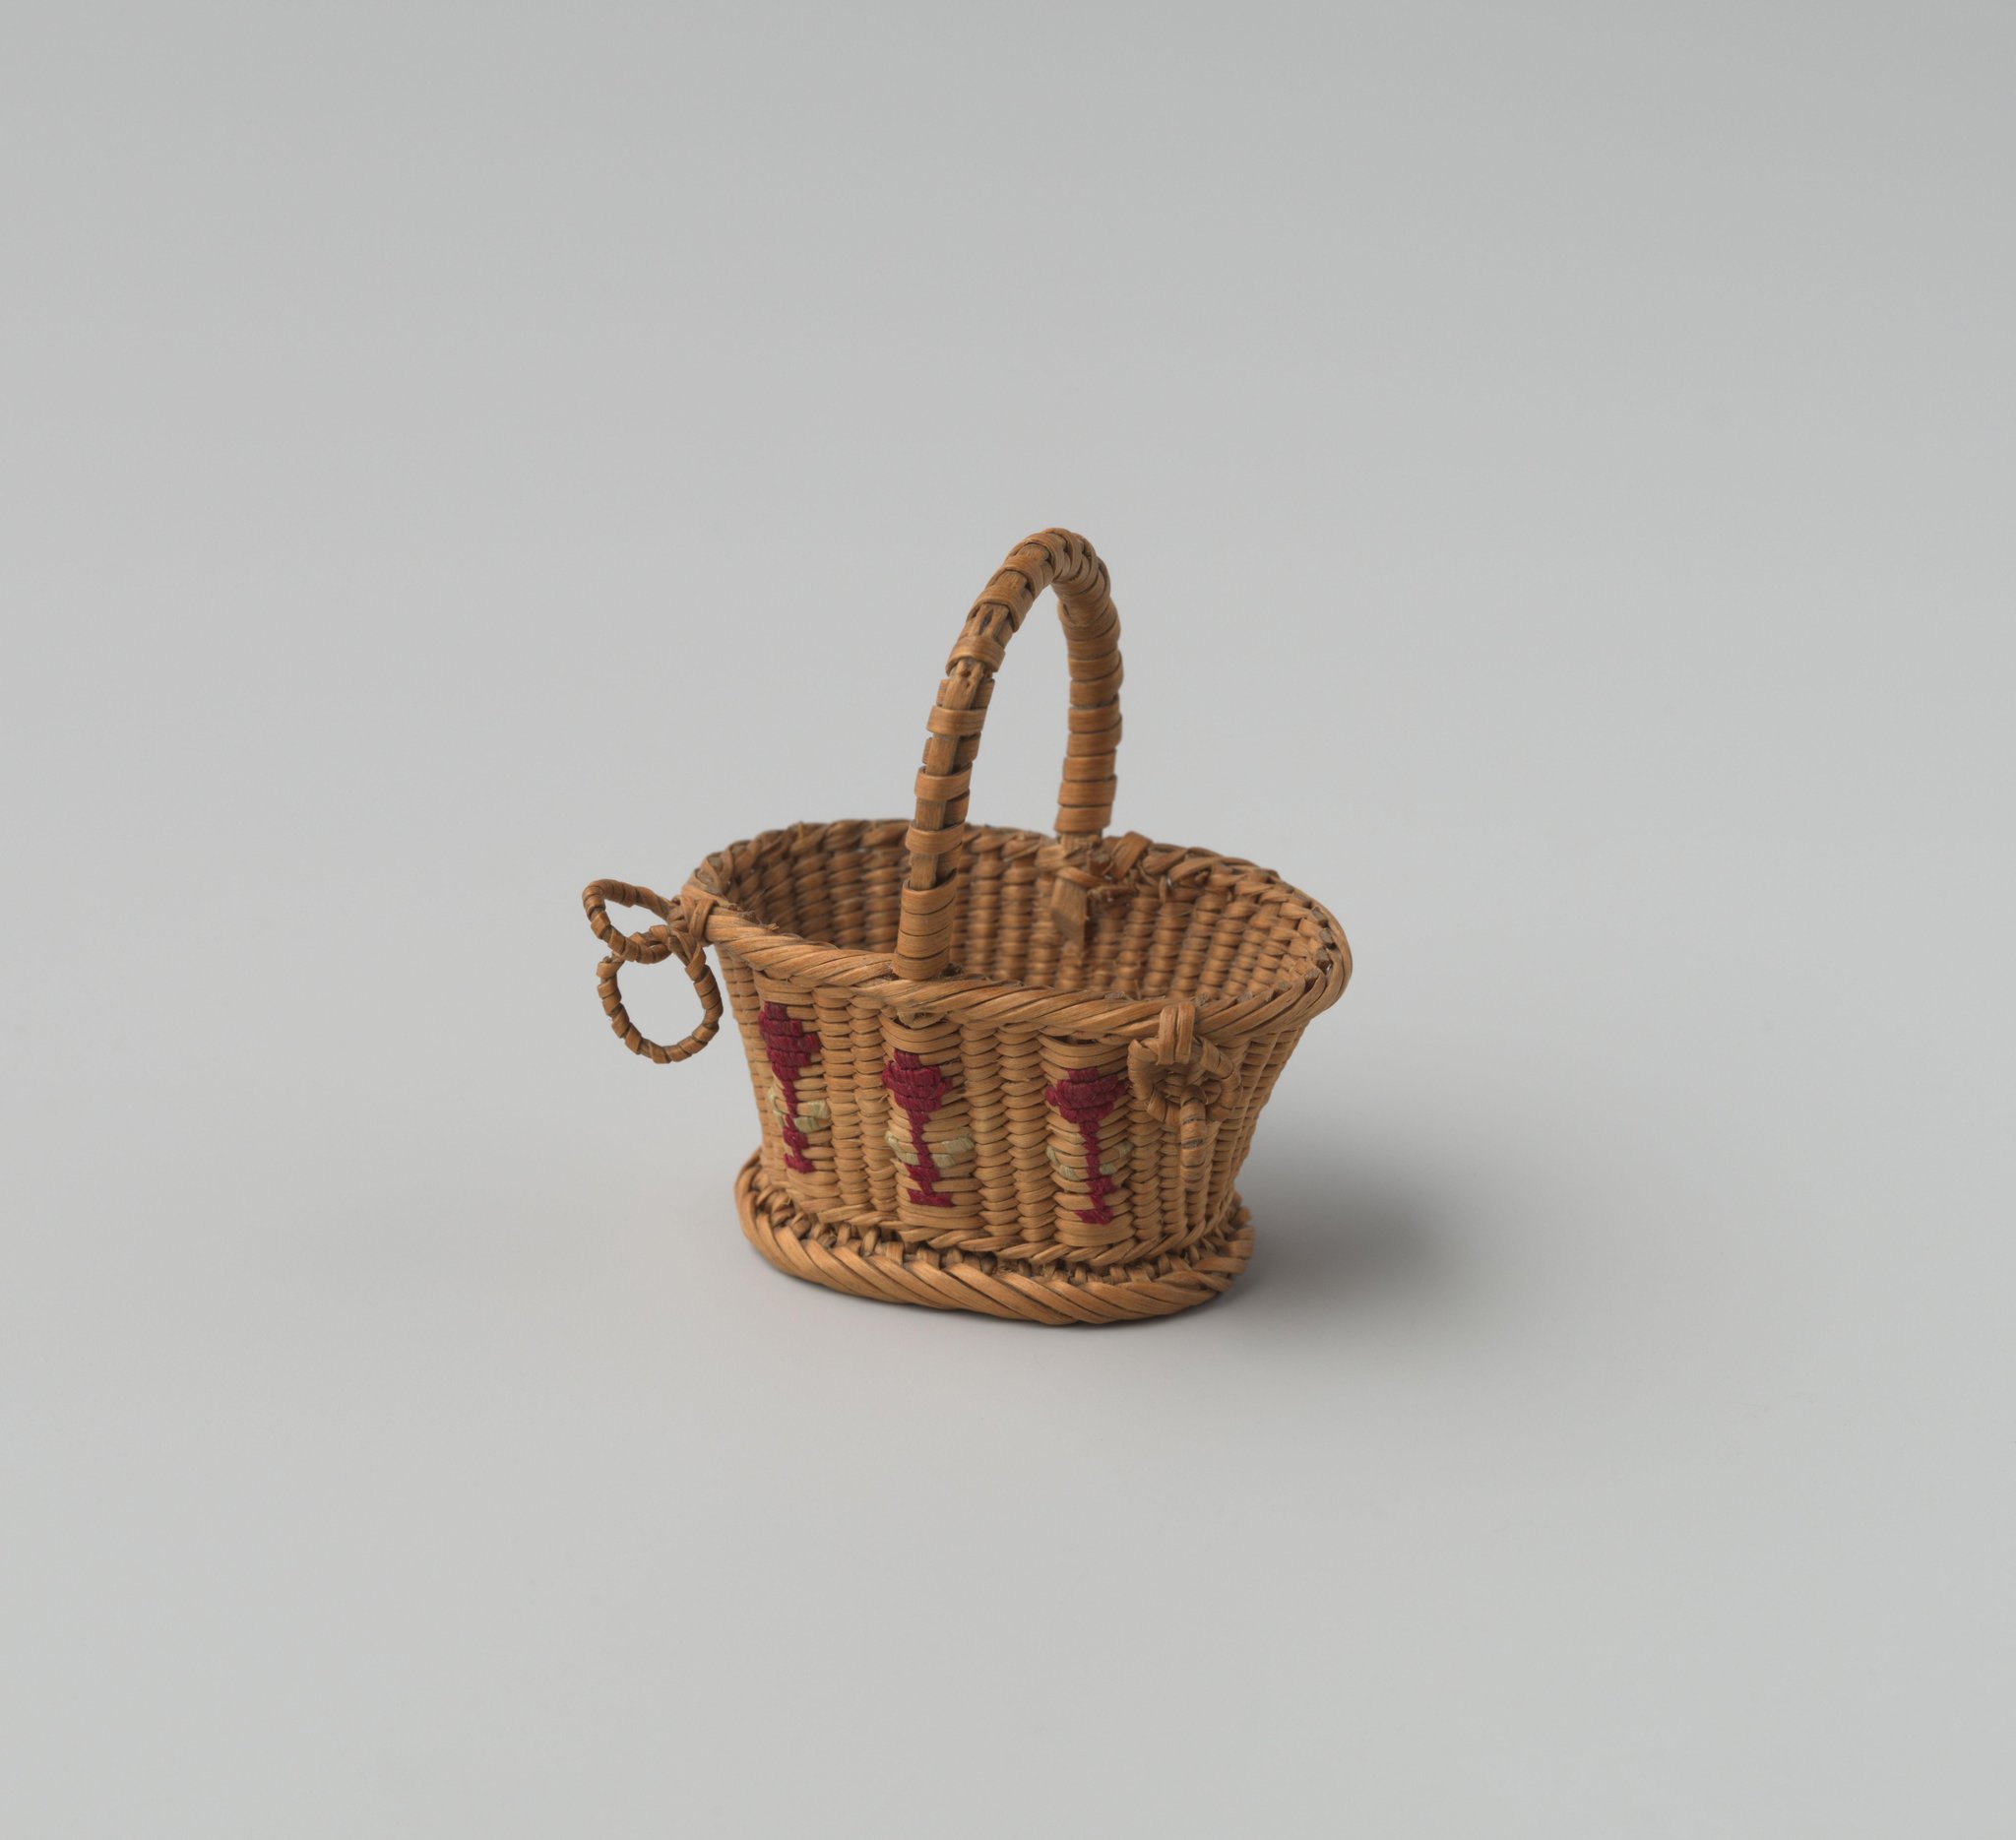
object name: miniature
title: Ovale hengselmand van gespleten wilgenteen (fijnscheenwerk), aan één zijde geborduurd met bloemmotieven.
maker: Anonymous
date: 1675-1710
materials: plant material, silk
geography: halle